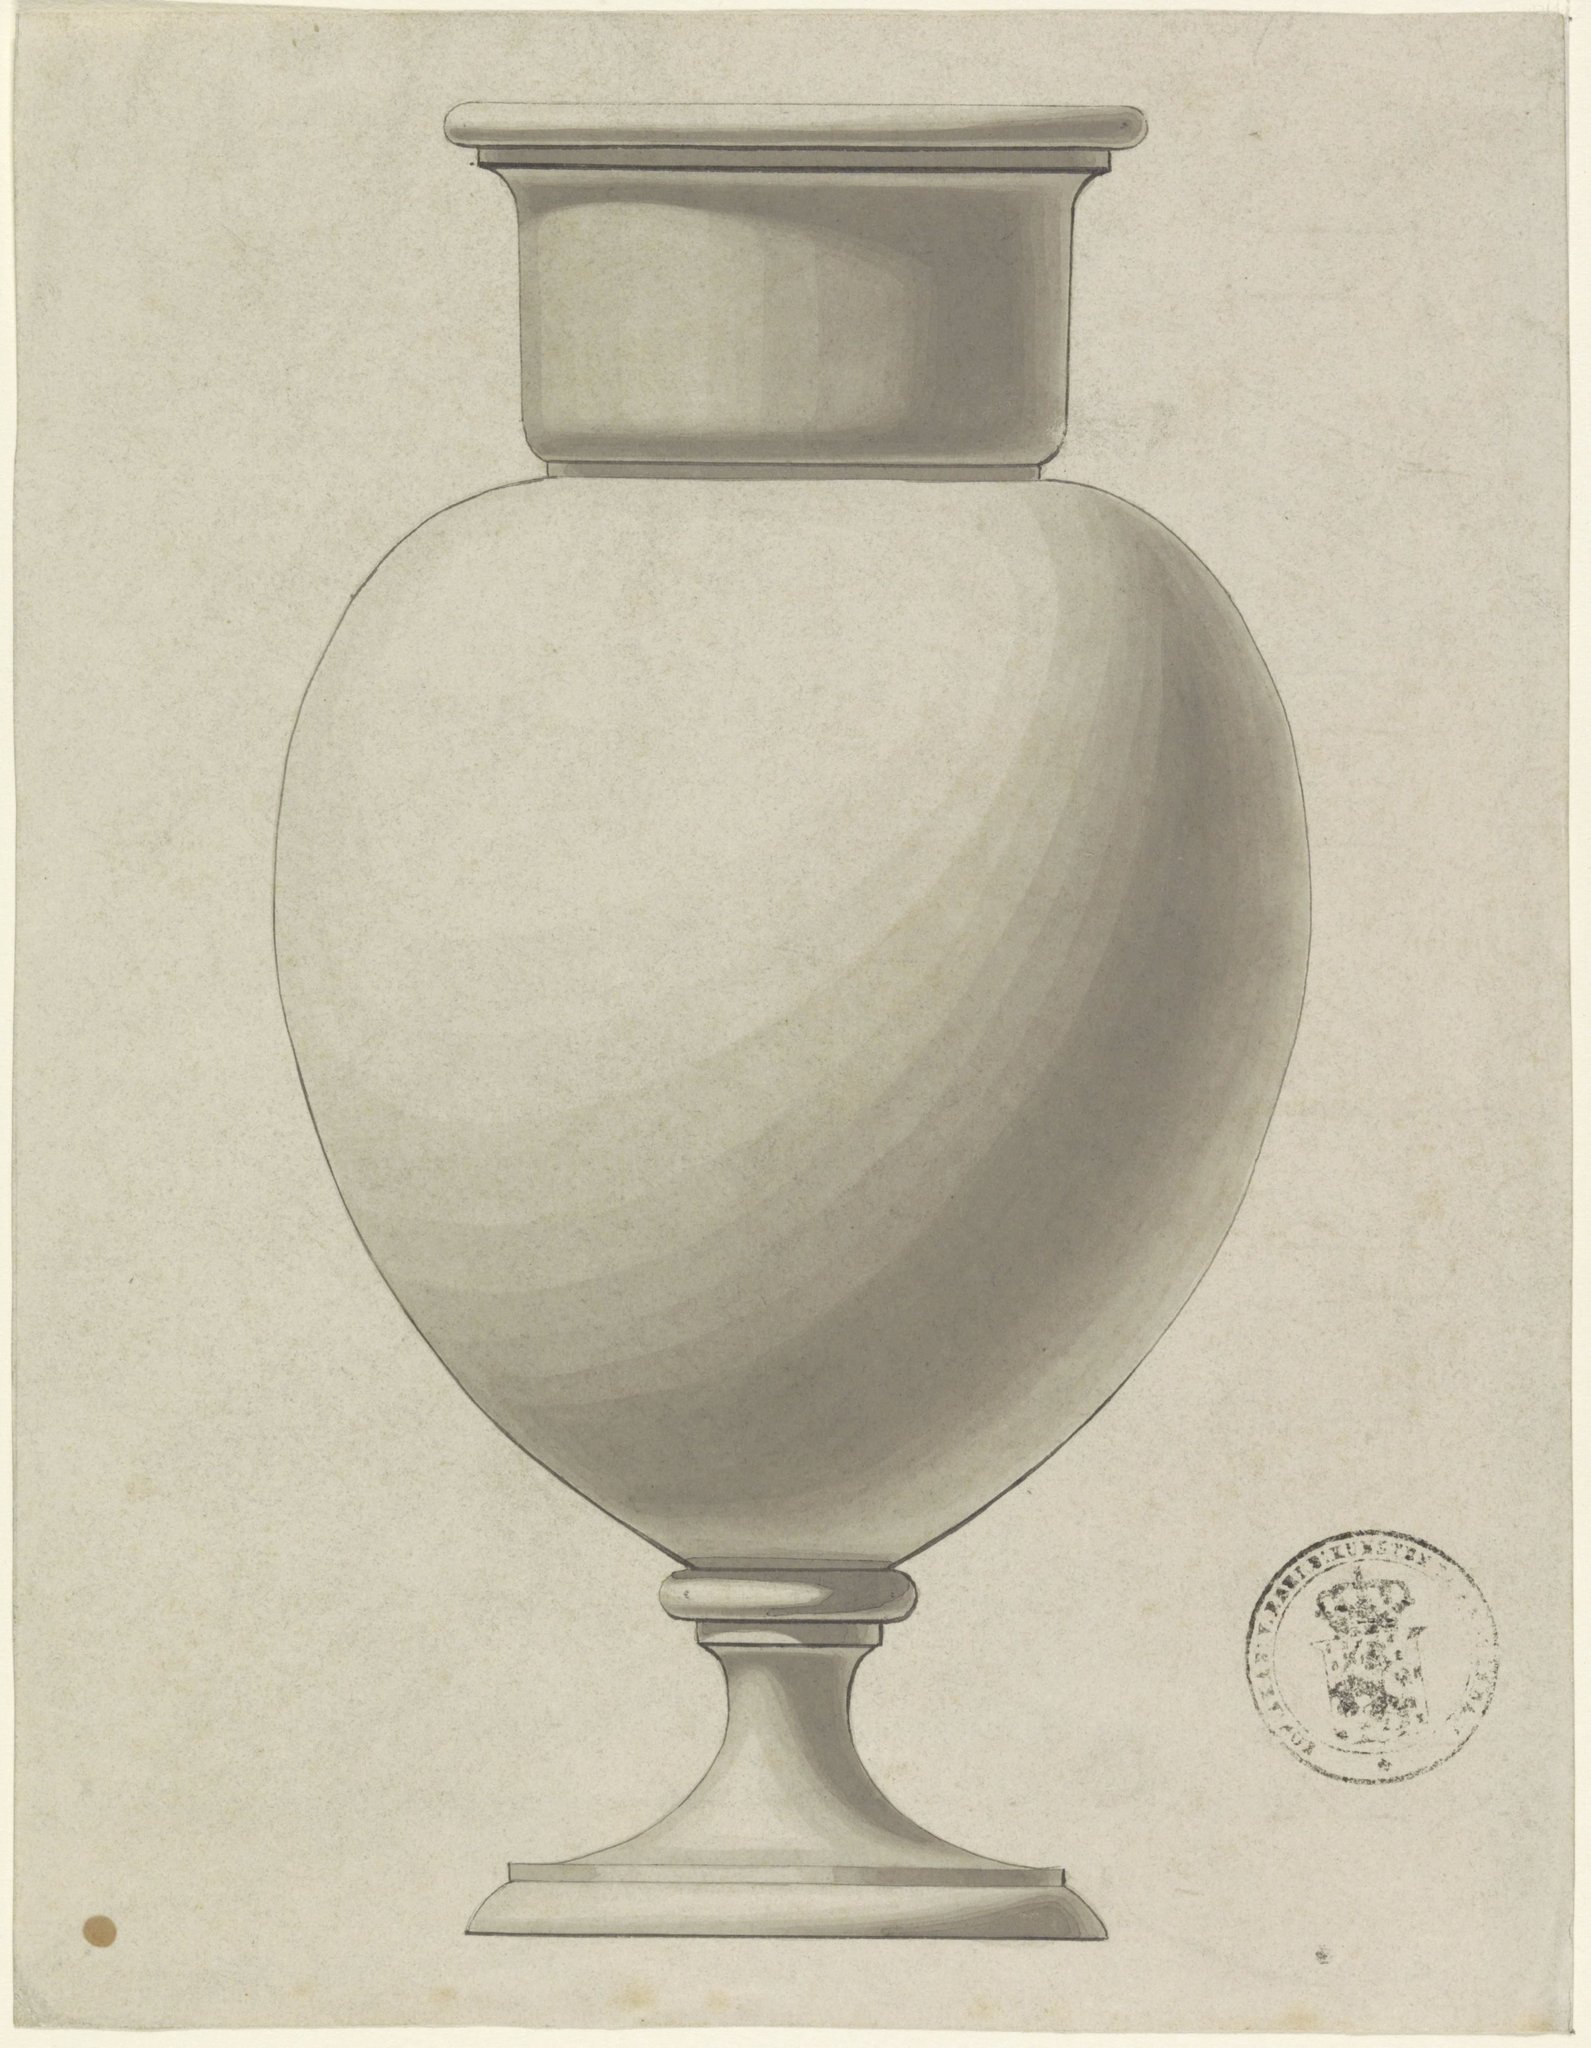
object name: ornamenttekening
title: Siervaas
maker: Anonymous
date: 1700-1900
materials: ink, paper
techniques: brush, pen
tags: vase ~ ornament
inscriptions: stamp: Lugt 10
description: Een siervaas met smalle voet en bolle buik.